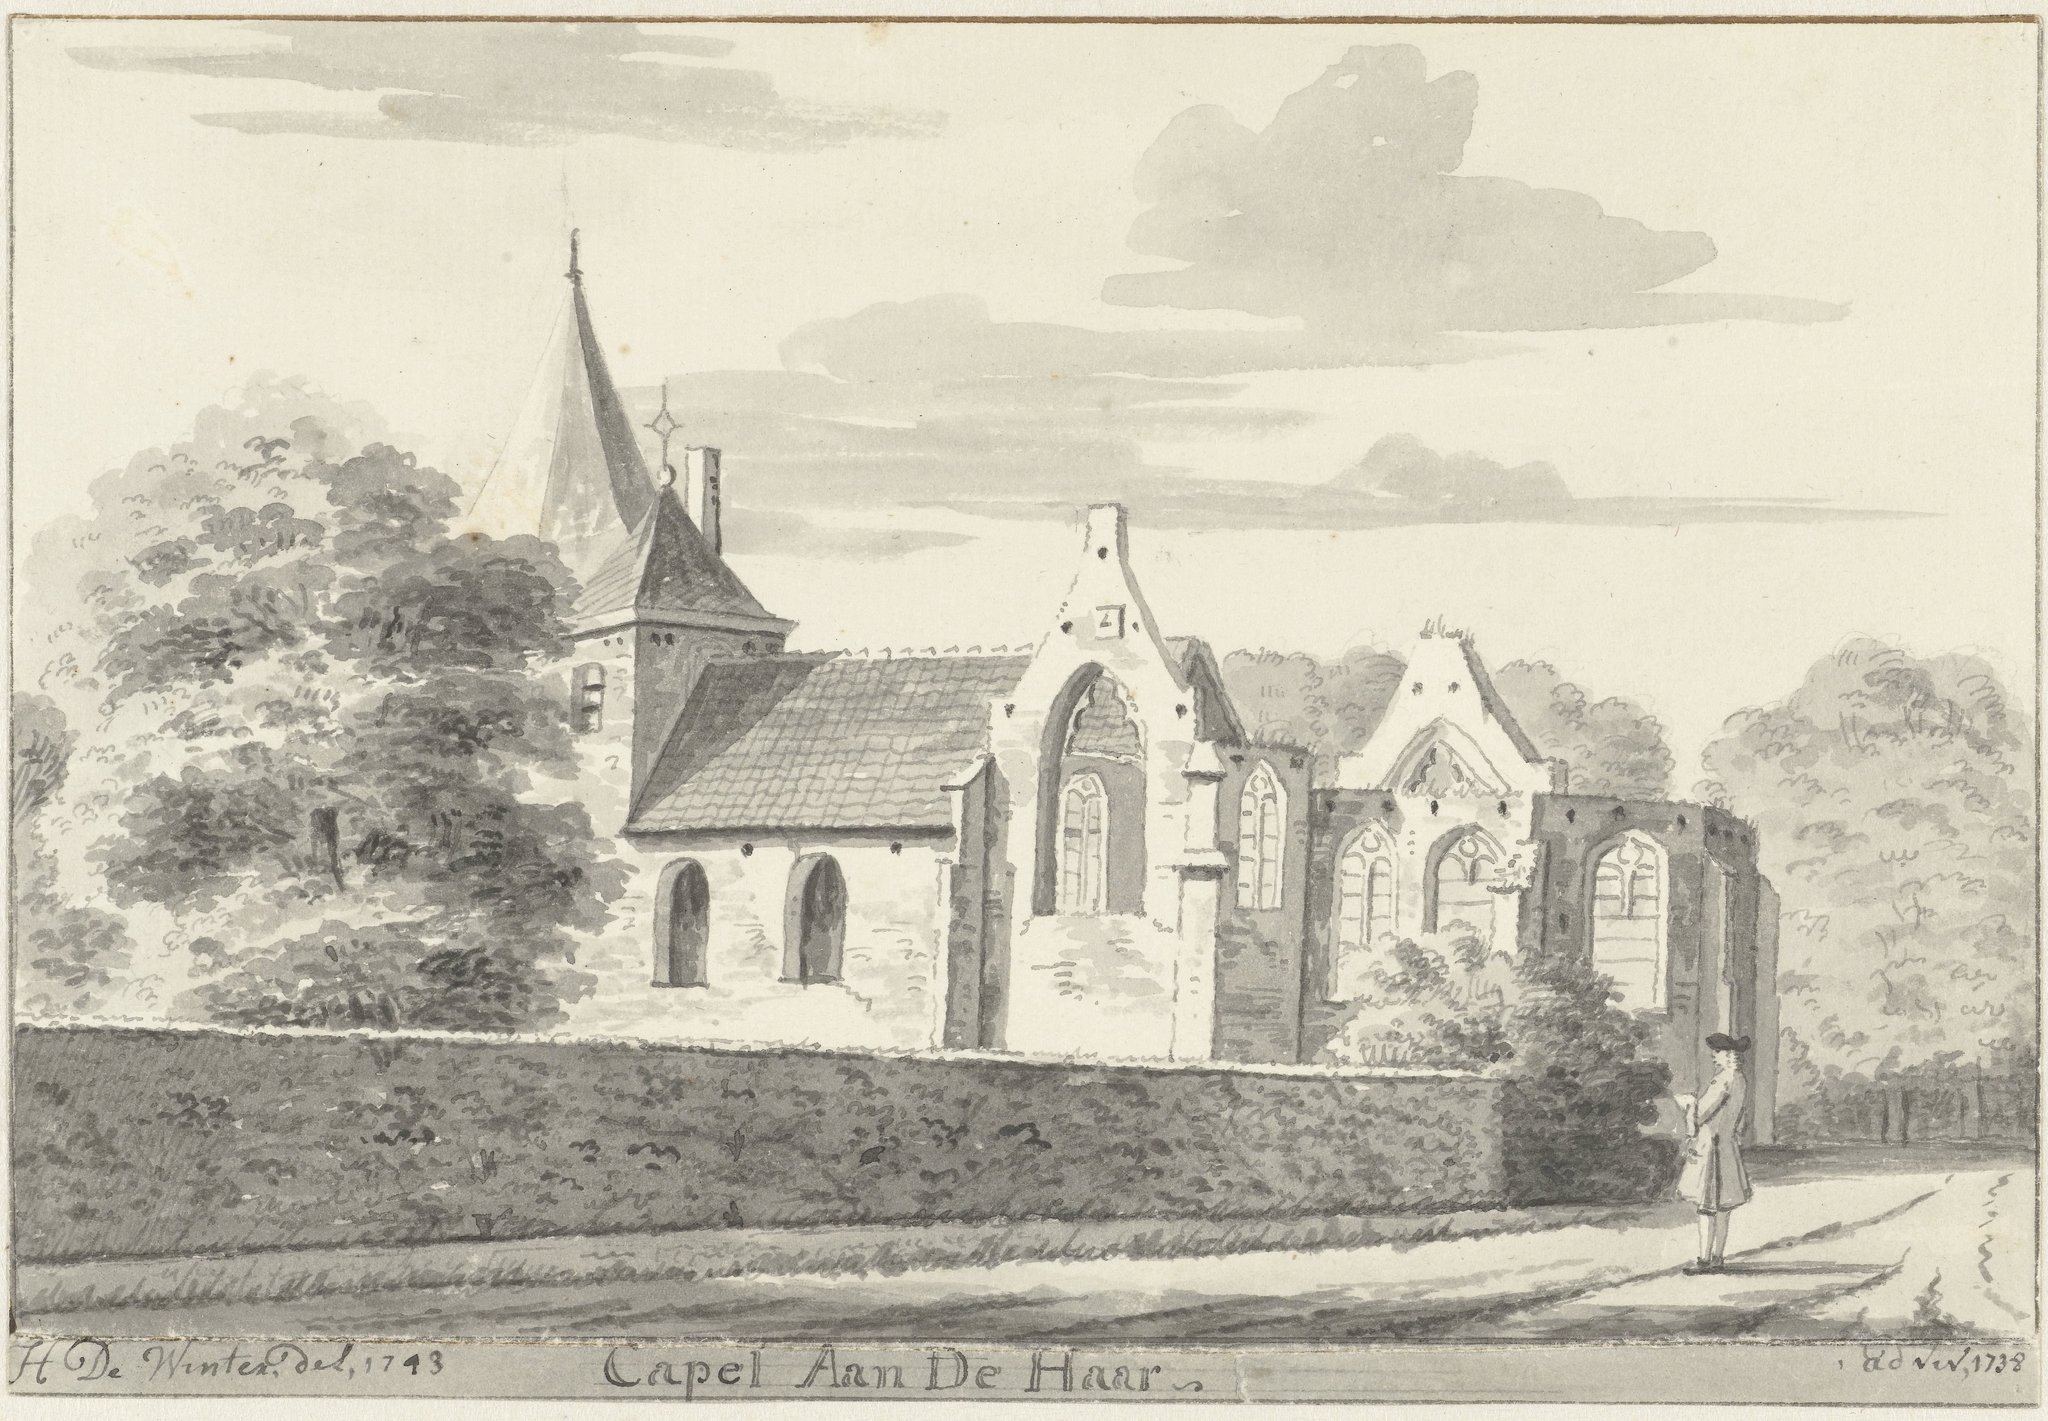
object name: drawing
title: De kapel aan de Haar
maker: hendrik de winter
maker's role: draughtsman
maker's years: 1717-1790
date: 1743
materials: ink, paper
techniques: brush, pen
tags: ruin of church, monastery, etc. - qq - small church, chapel, church (exterior) - qq - small church, chapel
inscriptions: inscription: ‘H De Winter del 1743 Capel Aan De Haar ad viv 1738’